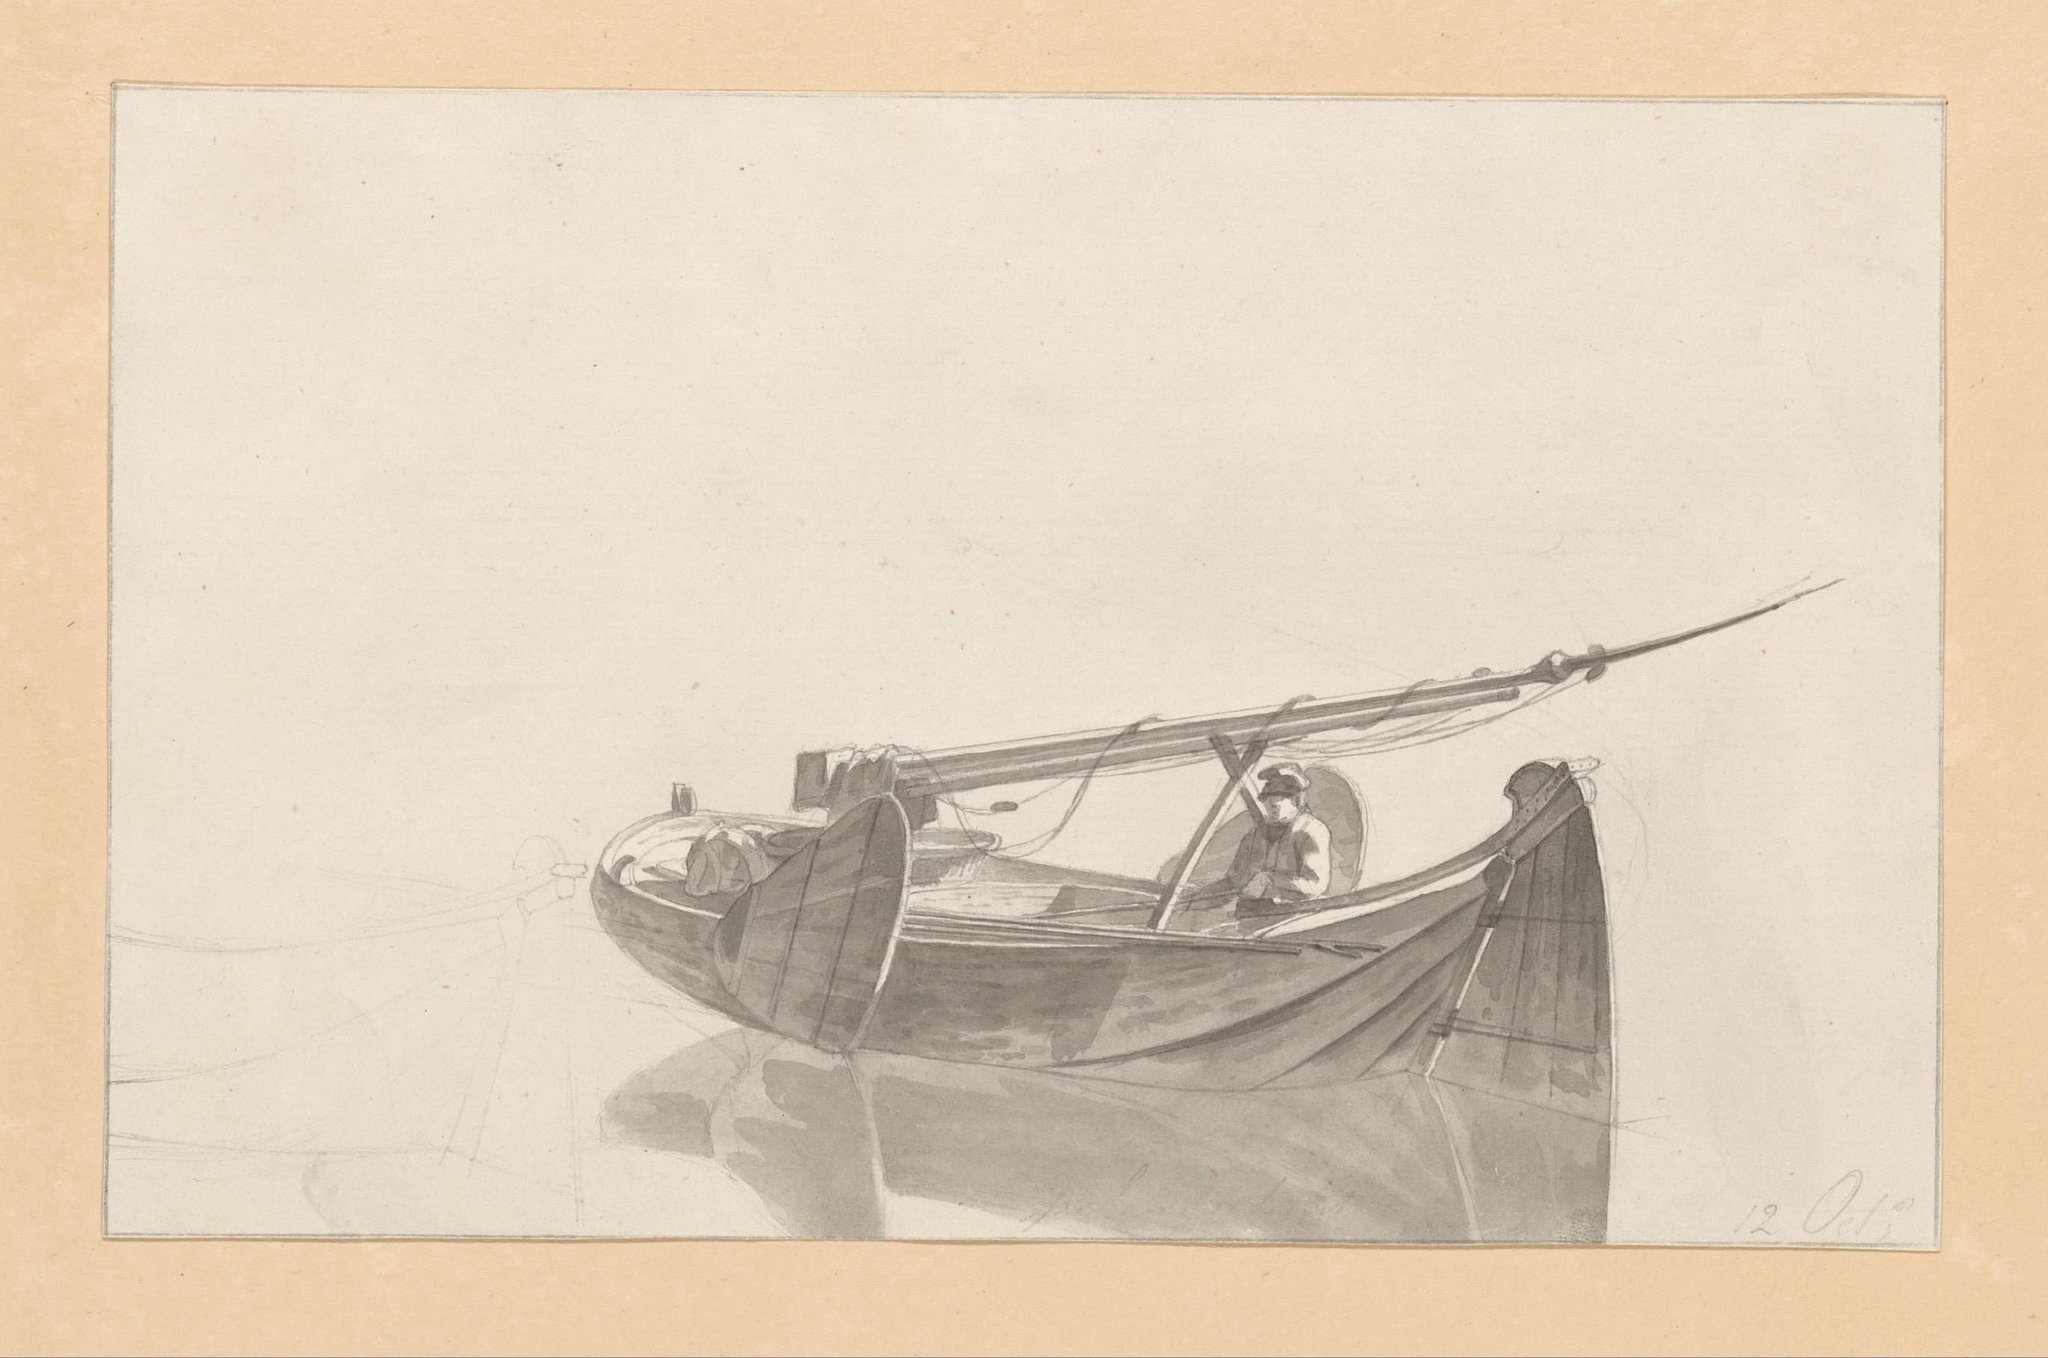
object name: drawing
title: Palingschuit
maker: hendrik abraham klinkhamer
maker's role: draughtsman, painter, print maker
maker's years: 1810-1872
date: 1820-1872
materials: paper, pencil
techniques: brush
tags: sailing-ship, sailing-boat